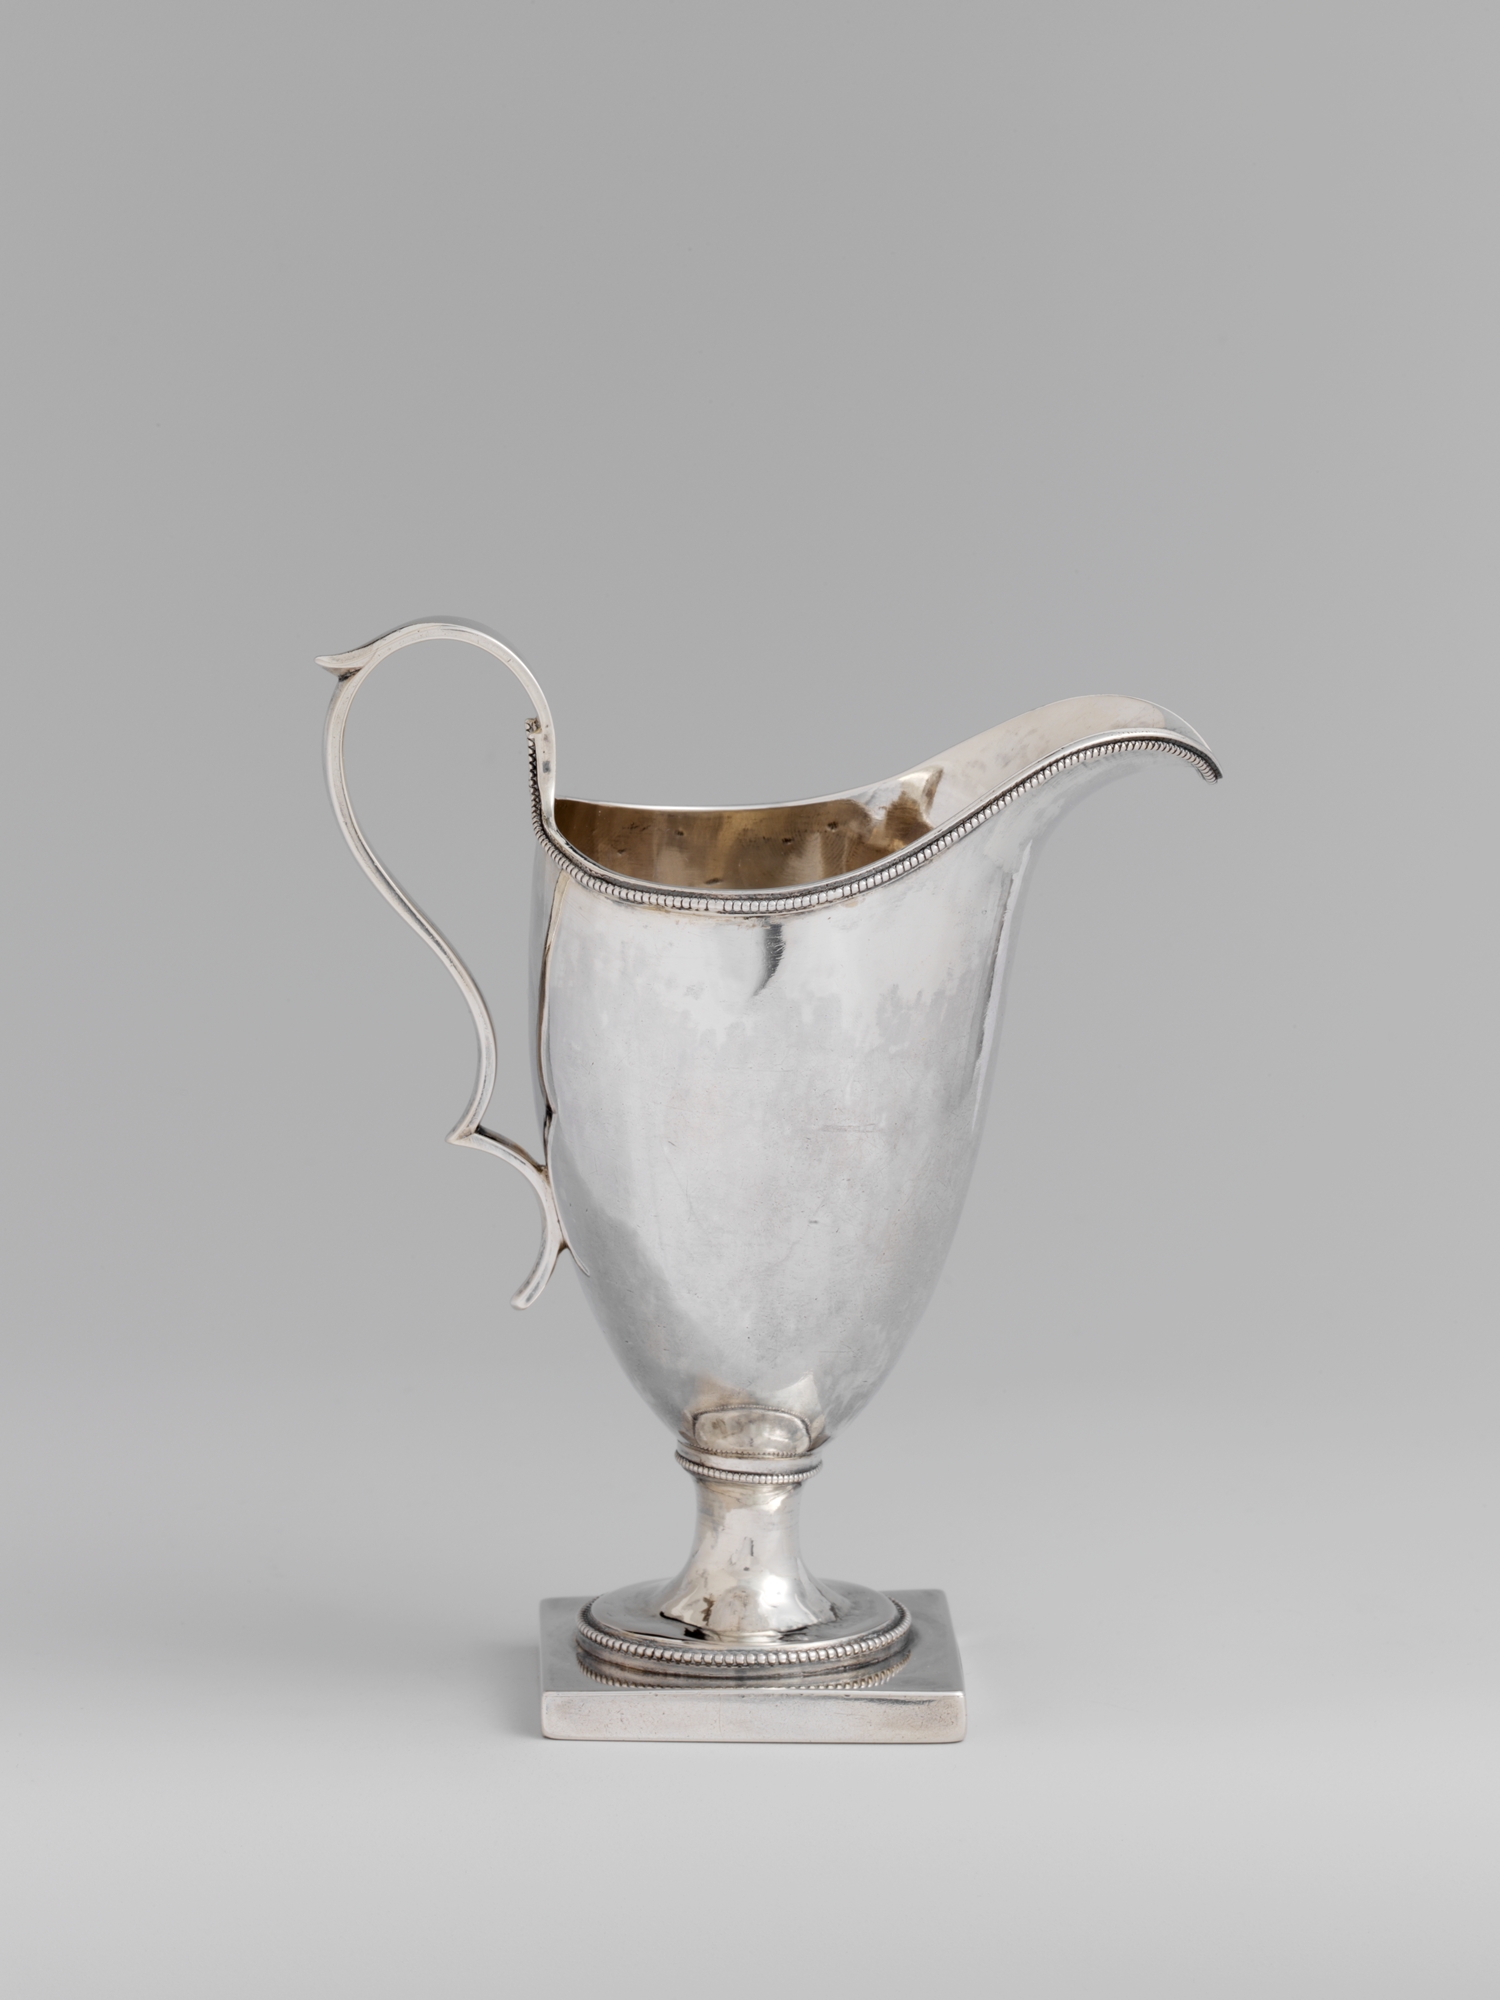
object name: cream pot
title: Creampot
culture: american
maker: stephen reeves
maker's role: maker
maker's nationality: american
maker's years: 1764-1776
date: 1775-1800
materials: silver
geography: united states